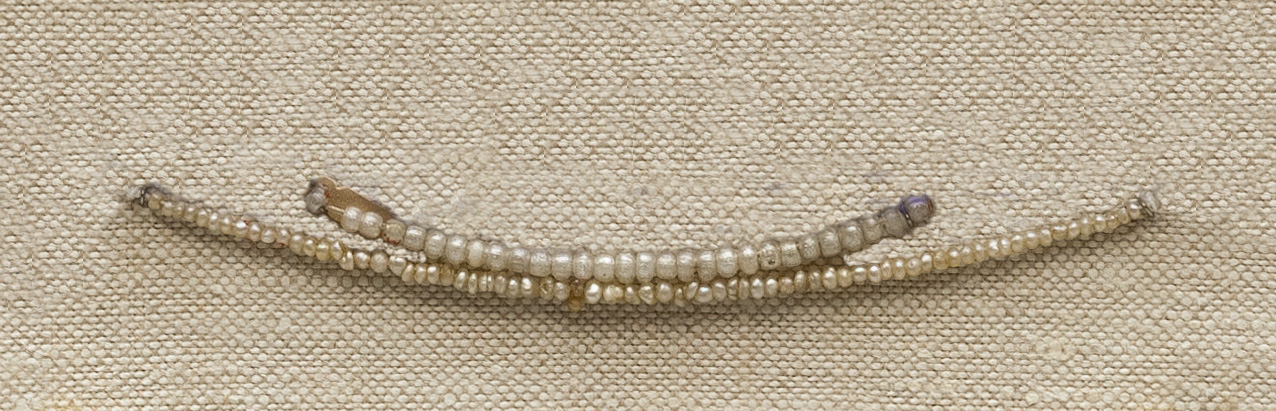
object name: necklace, pearl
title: String of Pearls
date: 200-1 BCE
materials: pearl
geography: egypt